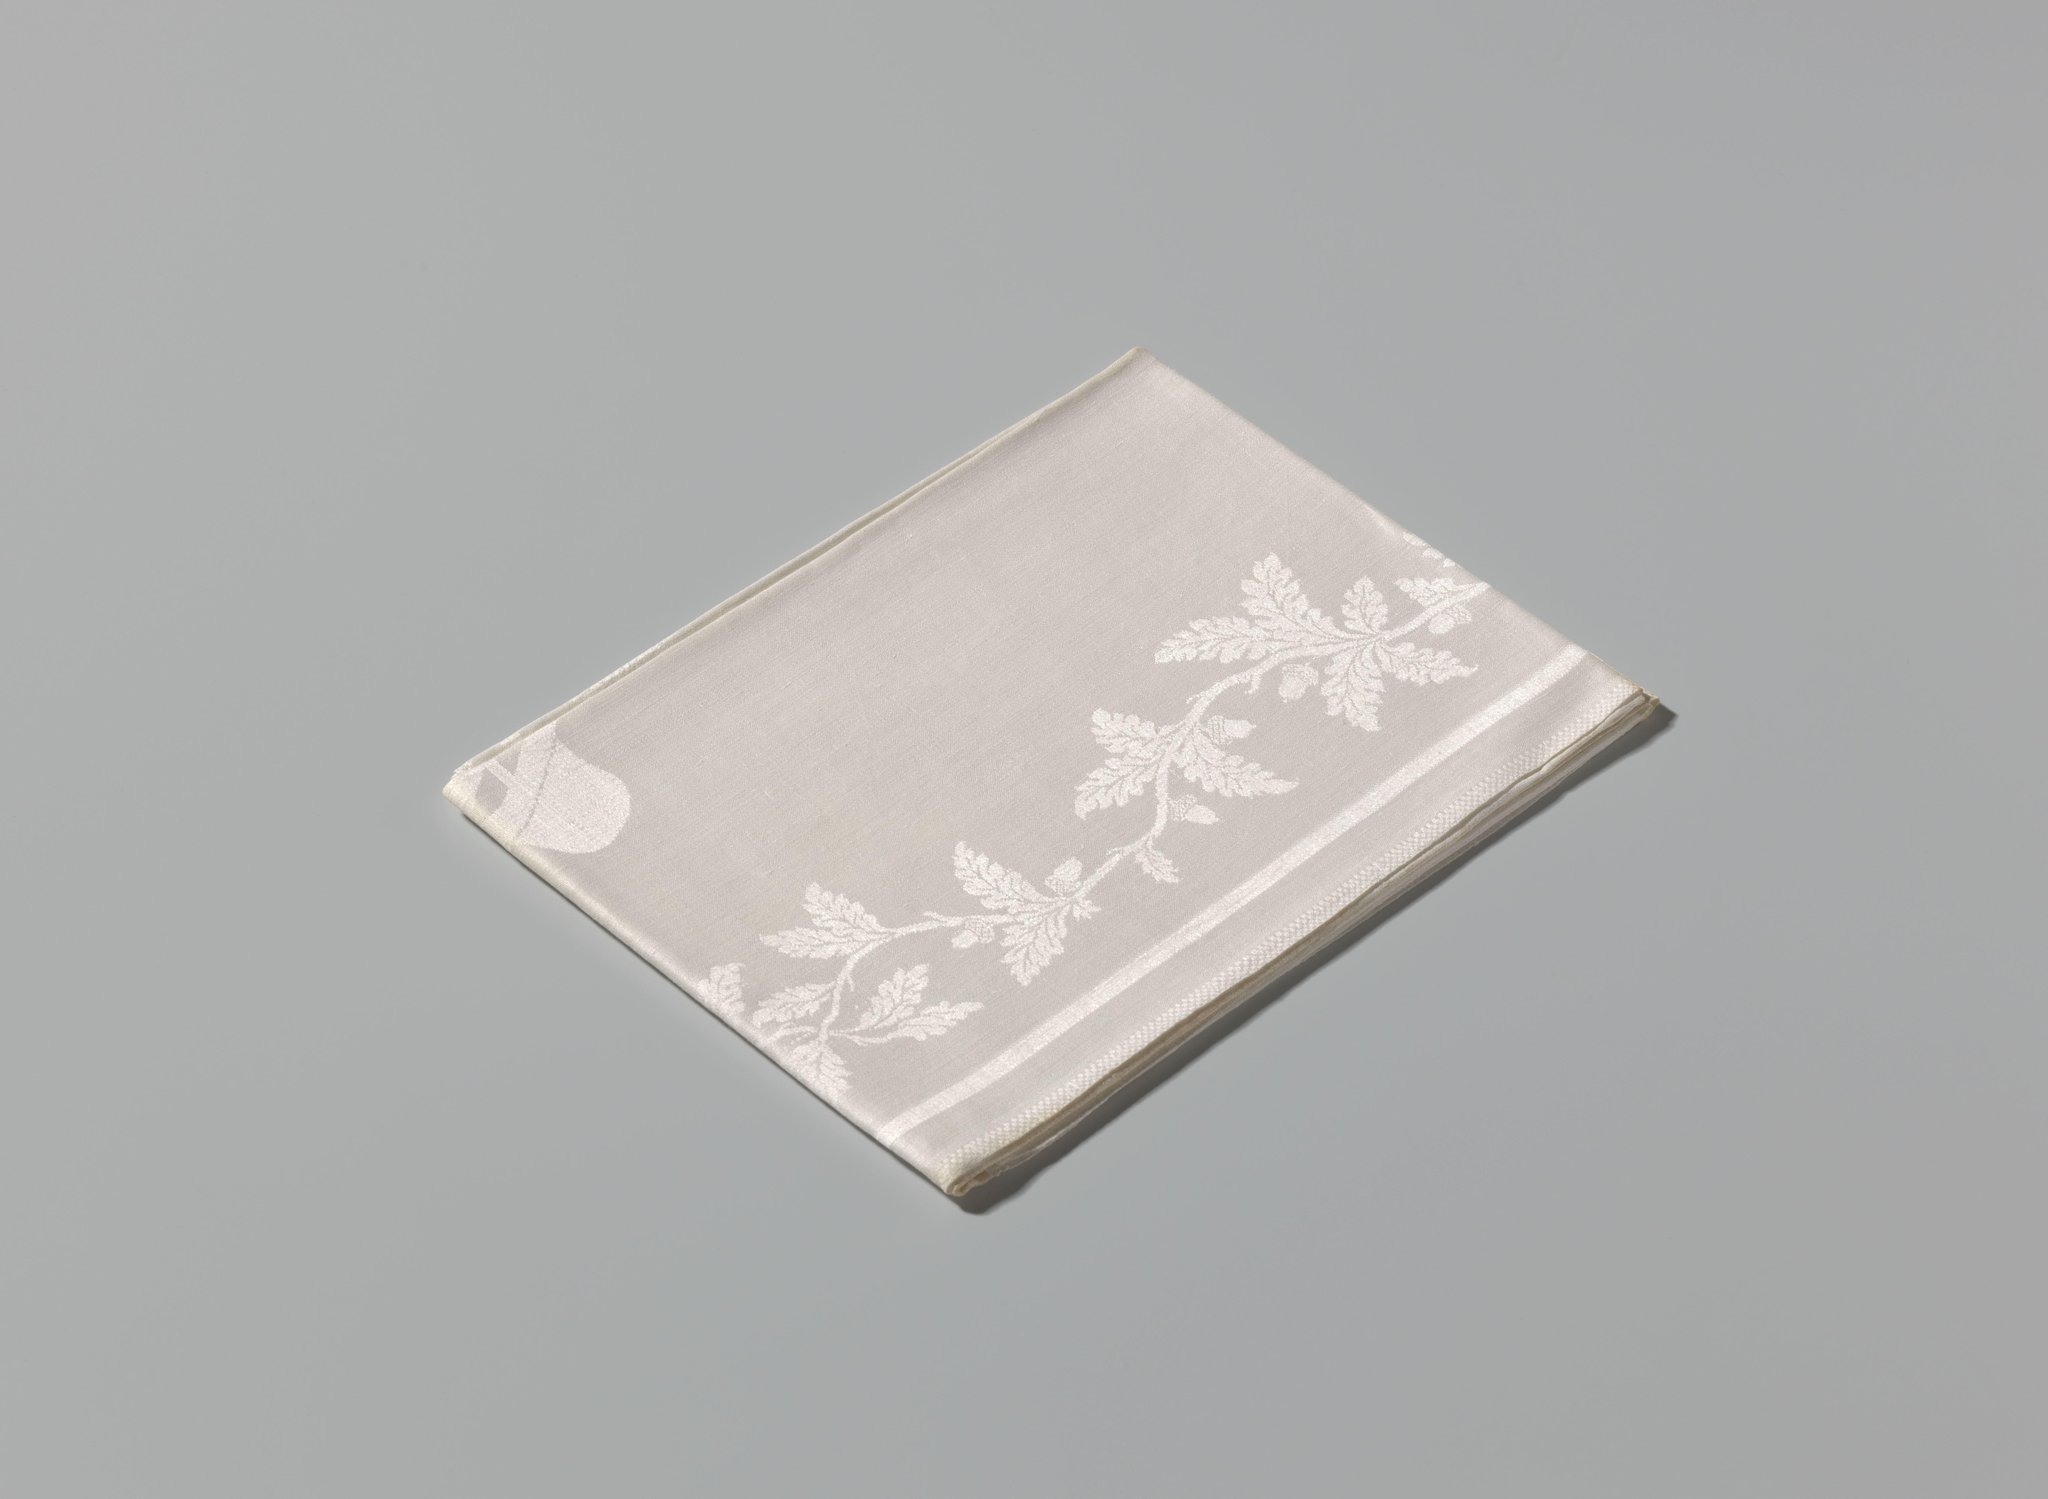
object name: napkin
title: Servet met het wapen van Wijk bij Duurstede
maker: Anonymous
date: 1786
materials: linen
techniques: damask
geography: north brabant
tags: wijk bij duurstede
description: Servet van linnendamast met het wapen van Wijk bij Duurstede. Middenveld: In de breedte geplaatst voor een speer met vrijheidshoed, het wapen van Wijk bij Duurstede: goud met balk van keel, beladen met drie zuilen; het is omgeven door twee lauwertakken en rust op een trofee van bajonetten, vlaggen, vuurmond en fascesbundel. Daaronder: 20 MAART Ao 1786 en daarboven DAN 36. Randen: slingerende tak met eikebladeren en eikels, een effen bandlijst en een blokkenrand.